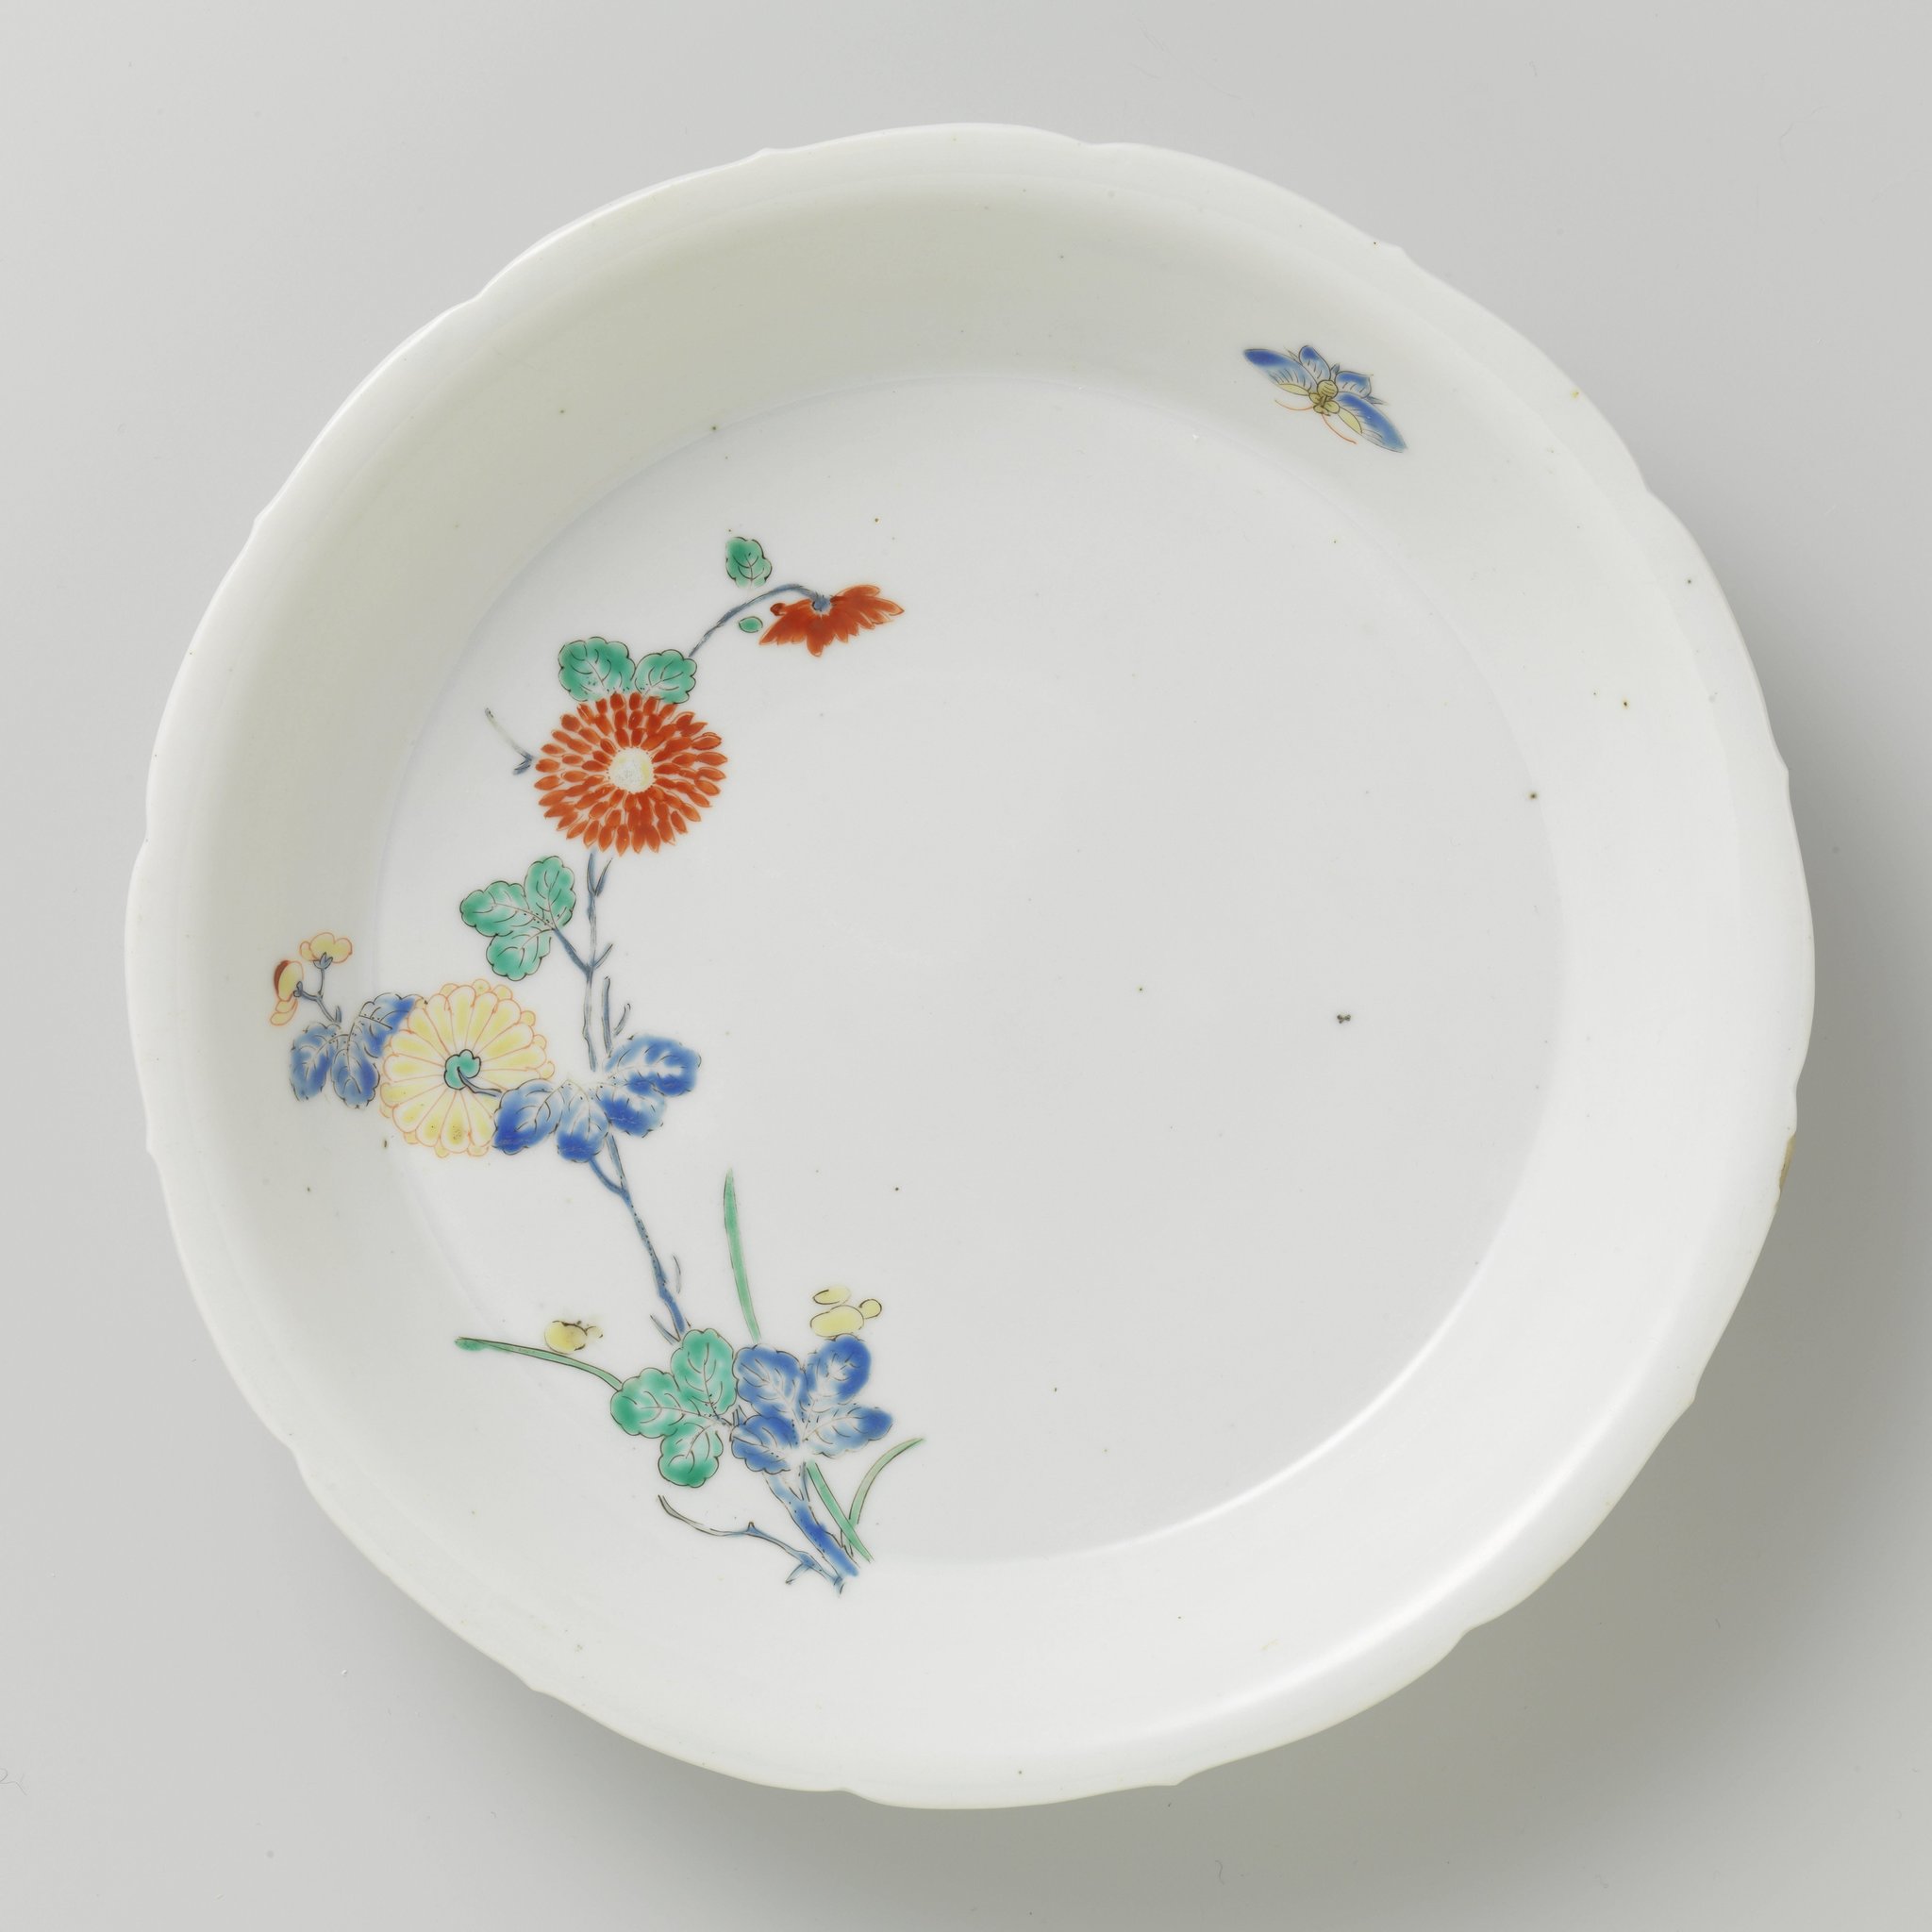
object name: plate dish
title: Scalloped dish with chrysanthemum and butterfly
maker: Anonymous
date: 1670-1690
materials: glaze, paint, porcelain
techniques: firing, turning, vitrification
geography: japan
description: Bord van porselein met een hoekig van het plat gescheiden, geschulpte rand. Beschilderd op het glazuur in blauw, rood, groen, geel en zwart met een chrsyantenbloesemtak en een vlinder. Vijf proenen in de voetring. Twee chips in de rand. Kakiemon.